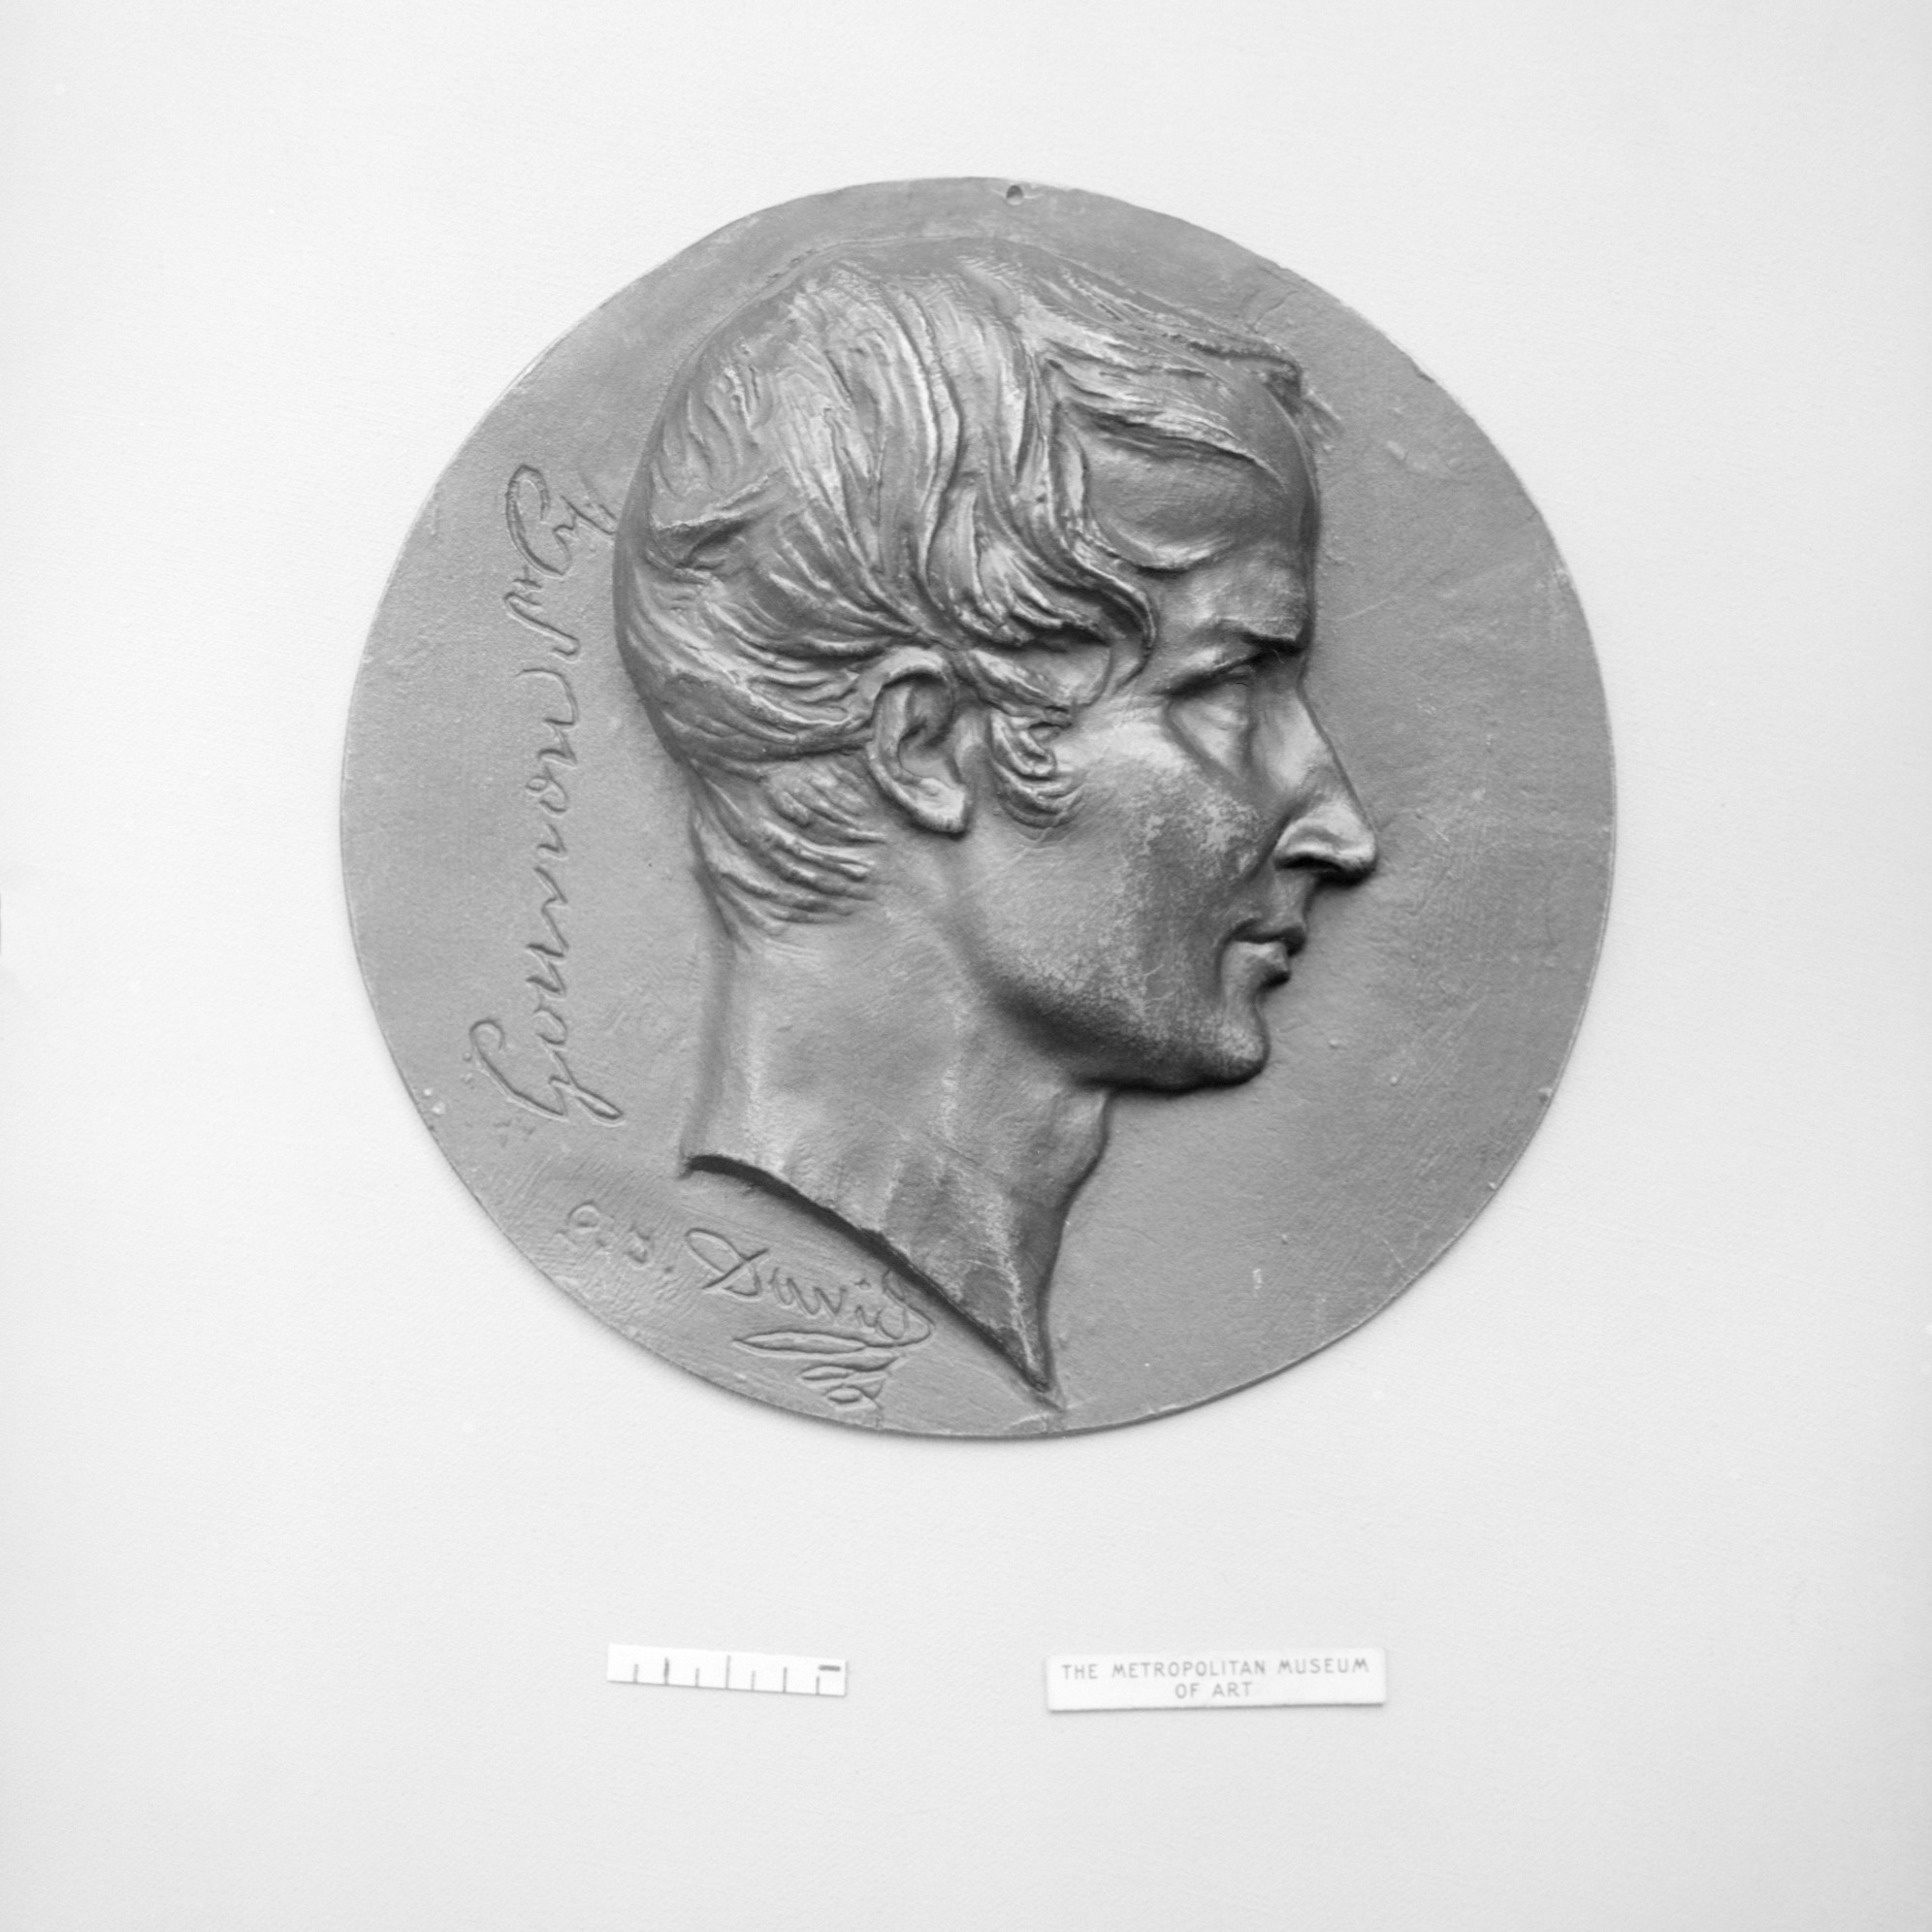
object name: medallion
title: Laurent Gouvion Saint-Cyr (1764–1830), Marshal of France, Minister of War 1815–1821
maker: pierre jean david d'angers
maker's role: artist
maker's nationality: french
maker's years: 1788-1856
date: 1832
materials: bronze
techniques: casting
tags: men,profiles